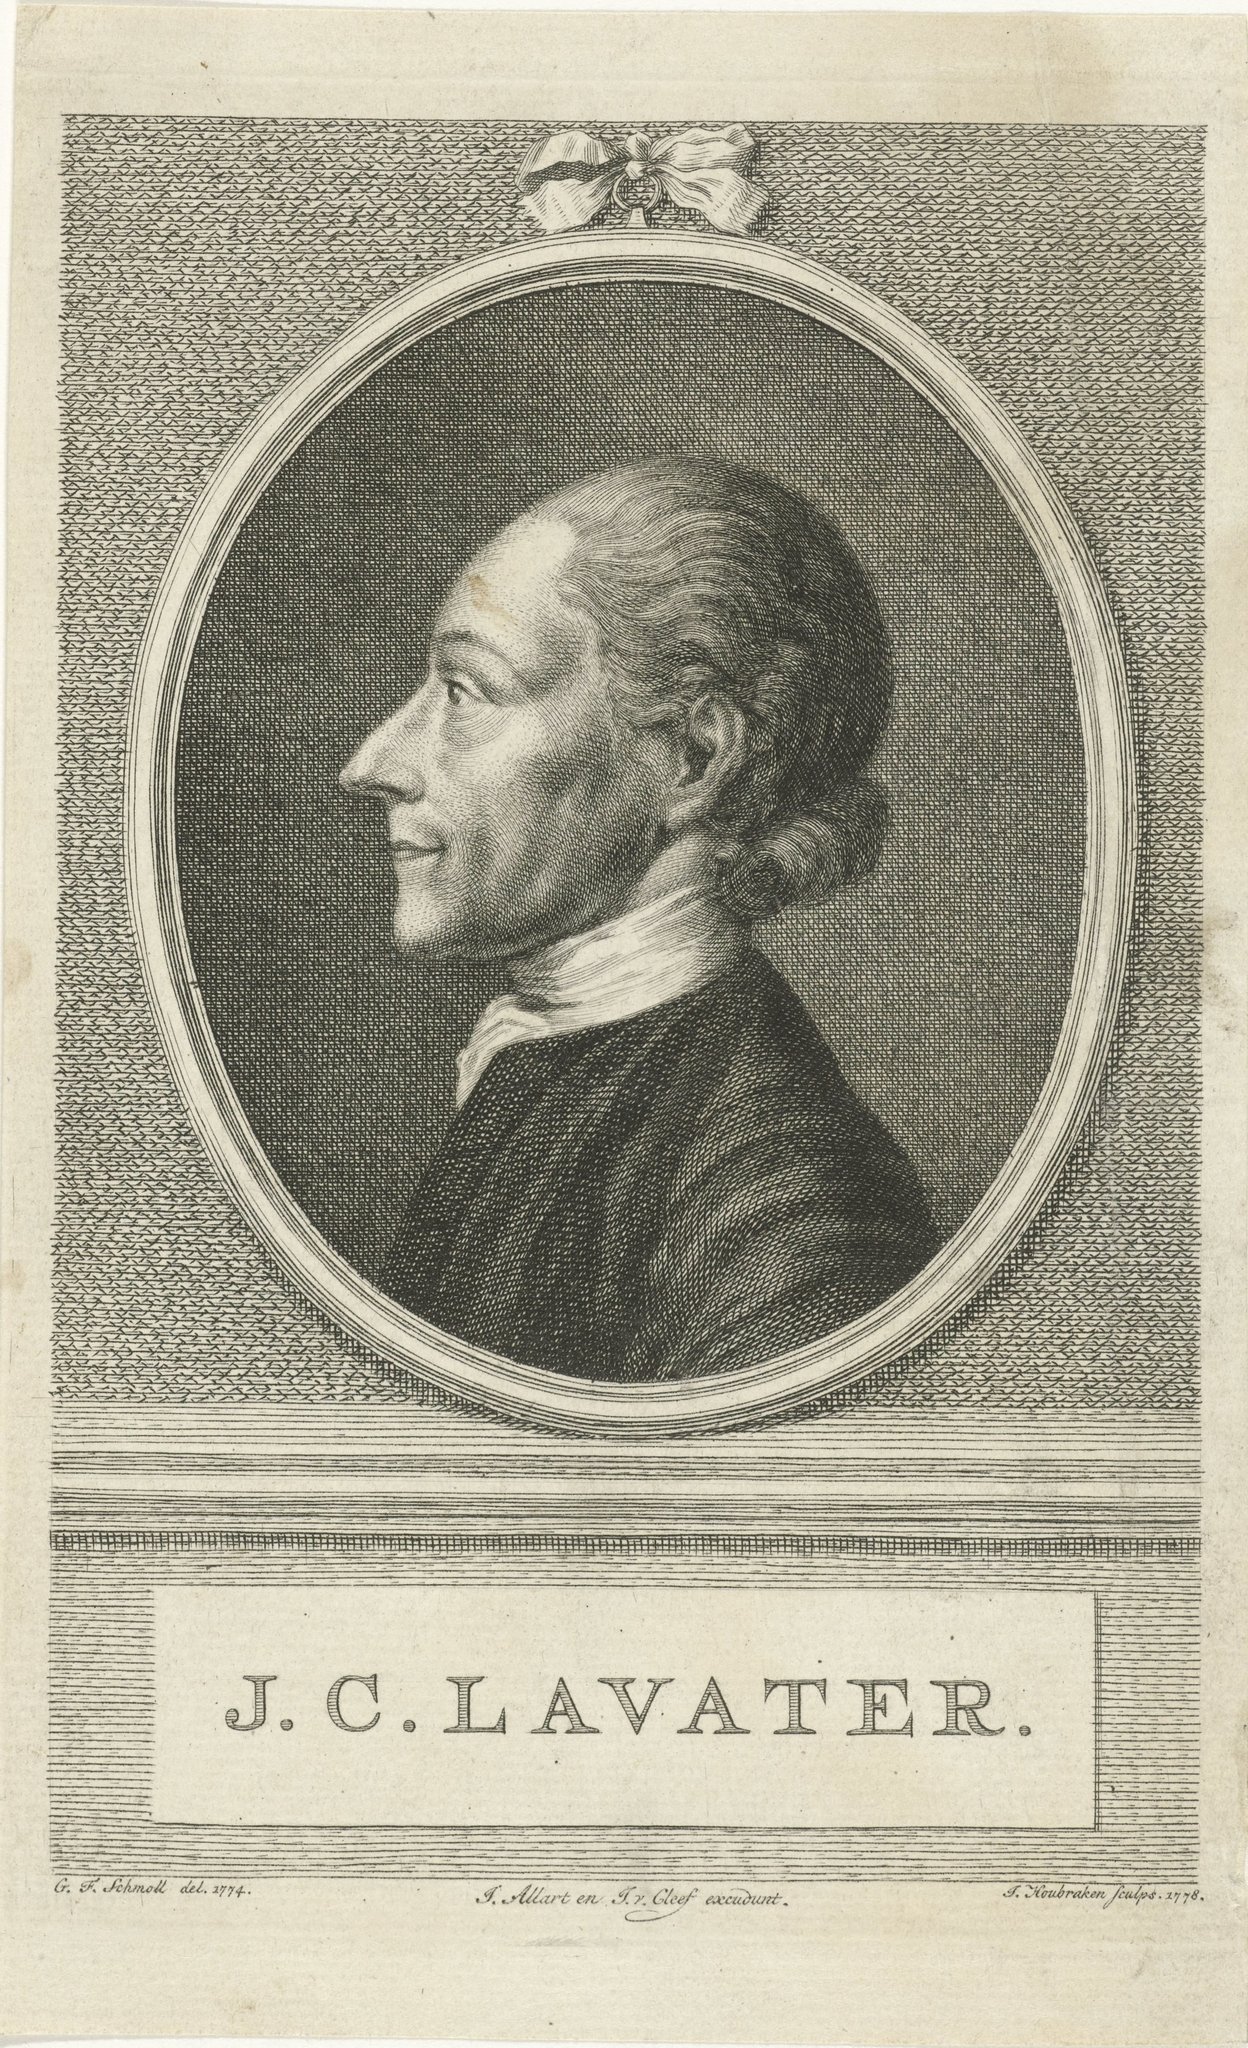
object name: print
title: Portret van Johann Kaspar Lavater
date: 1778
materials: paper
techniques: engraving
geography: amsterdam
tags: johann caspar lavater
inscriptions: collector's mark: Lugt 2228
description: Buste naar links van Johann Kaspar Lavater in een ovaal medaillon met bovenaan een strik. Onder het portret een richel waarop zijn naam.